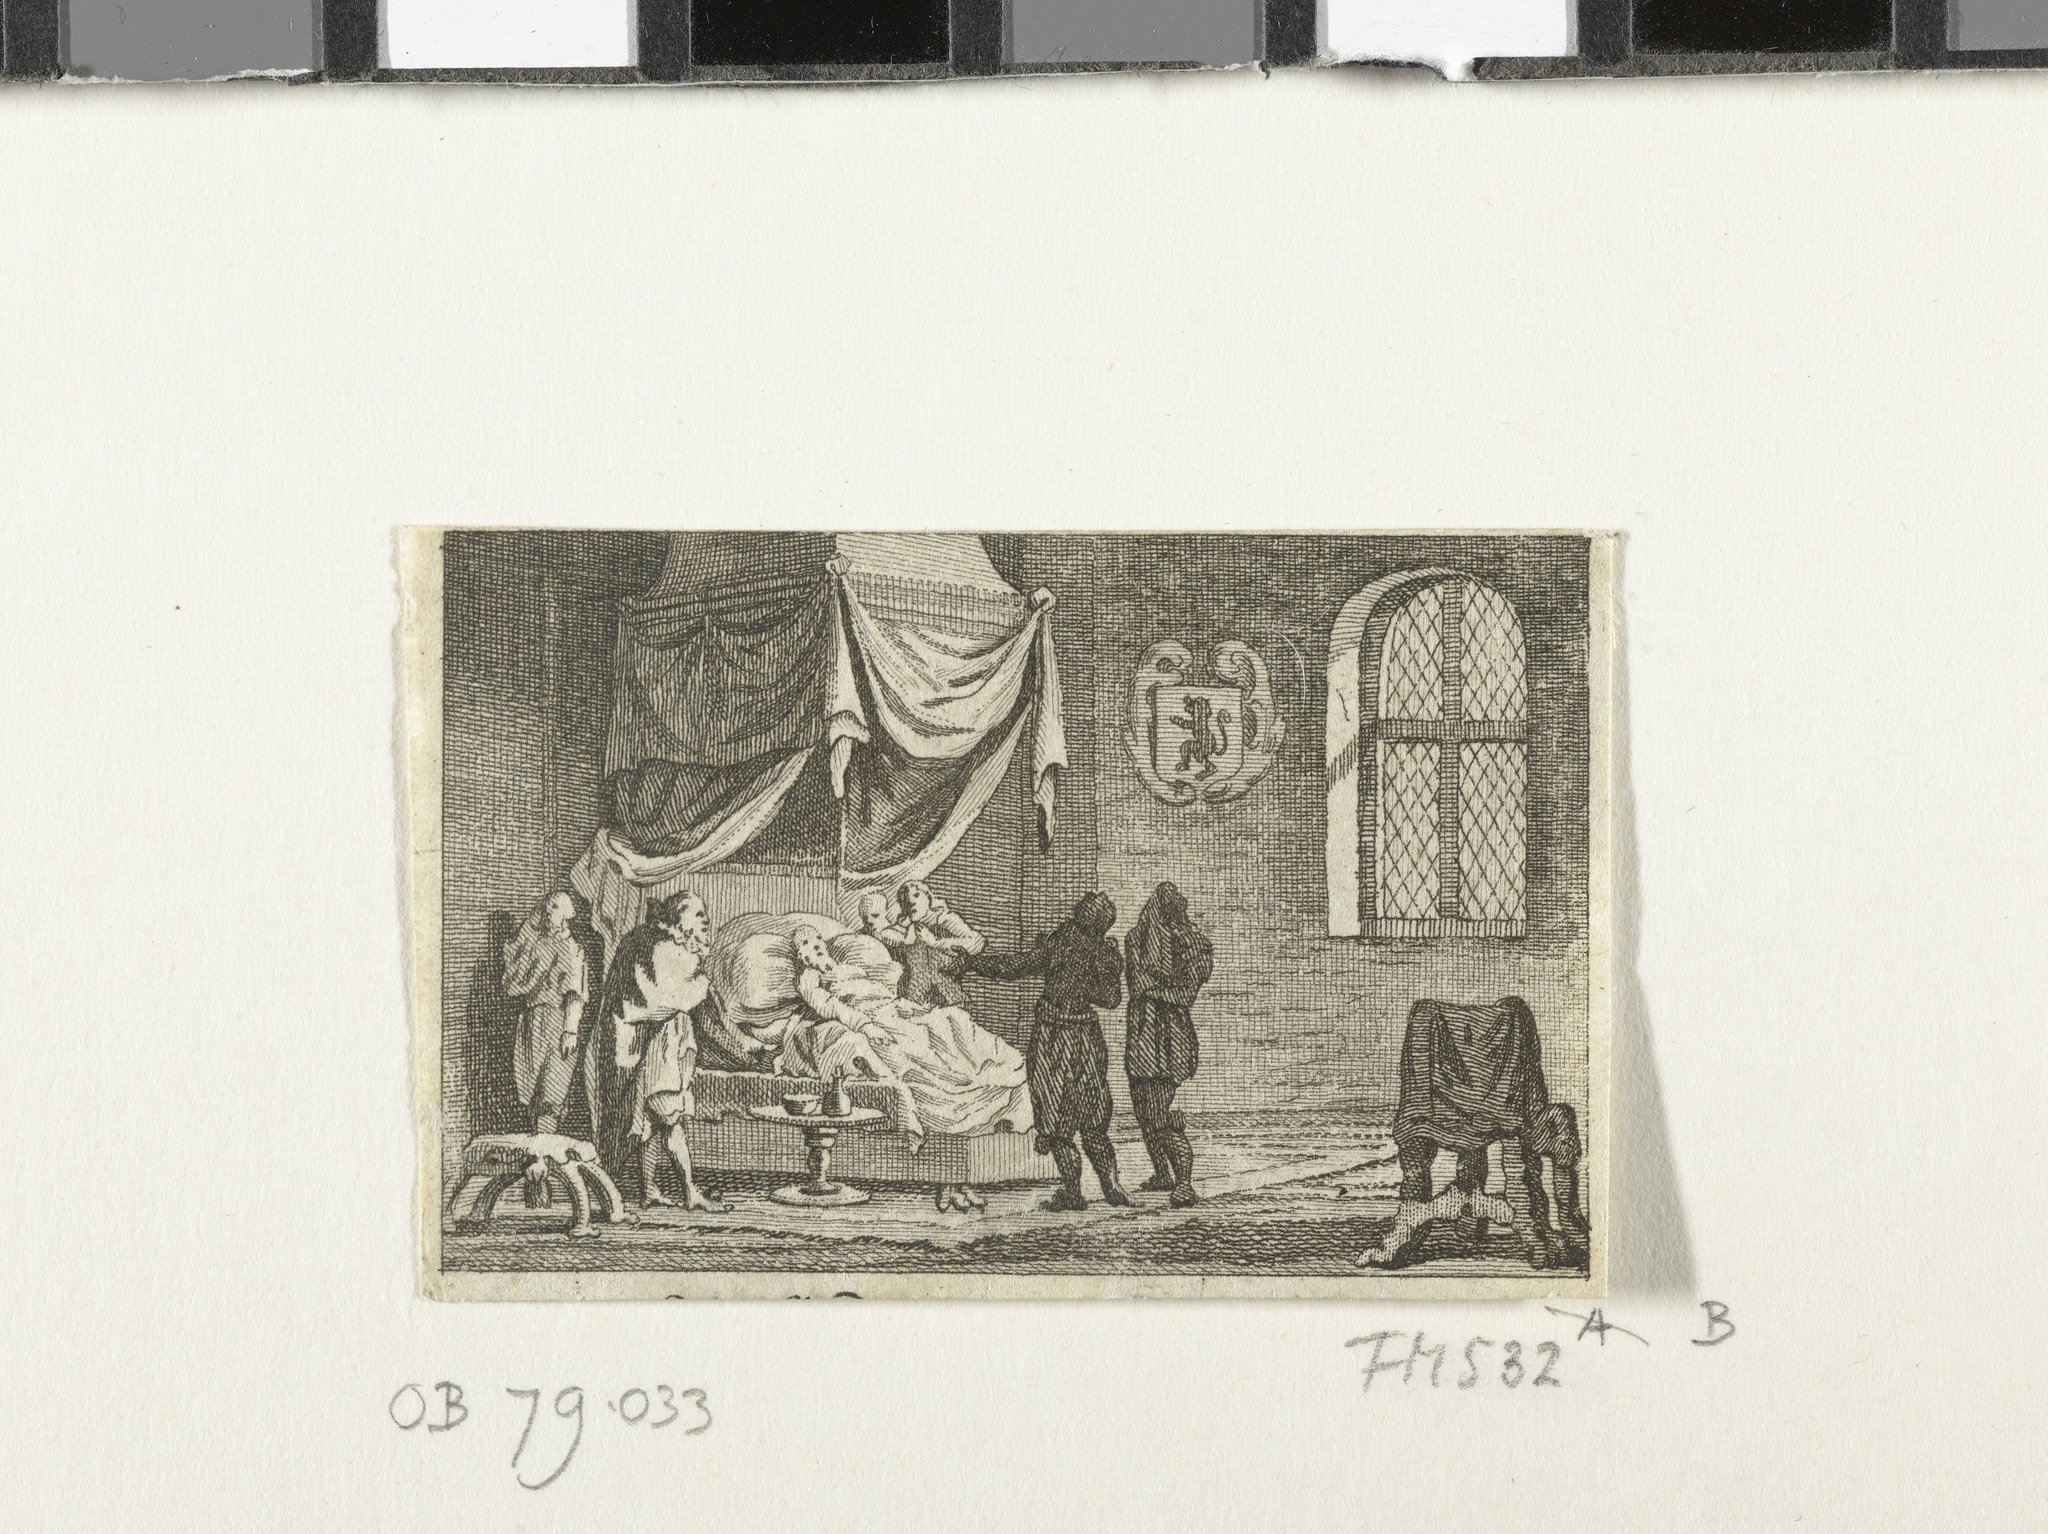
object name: print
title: Sterfbed van Brederode, 1568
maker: carel jacob de huyser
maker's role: print maker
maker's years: 1743-1804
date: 1794-1796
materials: paper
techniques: etching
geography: netherlands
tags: deathbed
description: Illustratie voor: Vaderlands zakboekje ter bevordering van wetenschappen en fraaije letteren, of Almanak voor het jaar 1796, weduwe J. Doll, Amsterdam, pl. nr. 2. Niet in Frederik Muller; door het RPK toegevoegd nummer.